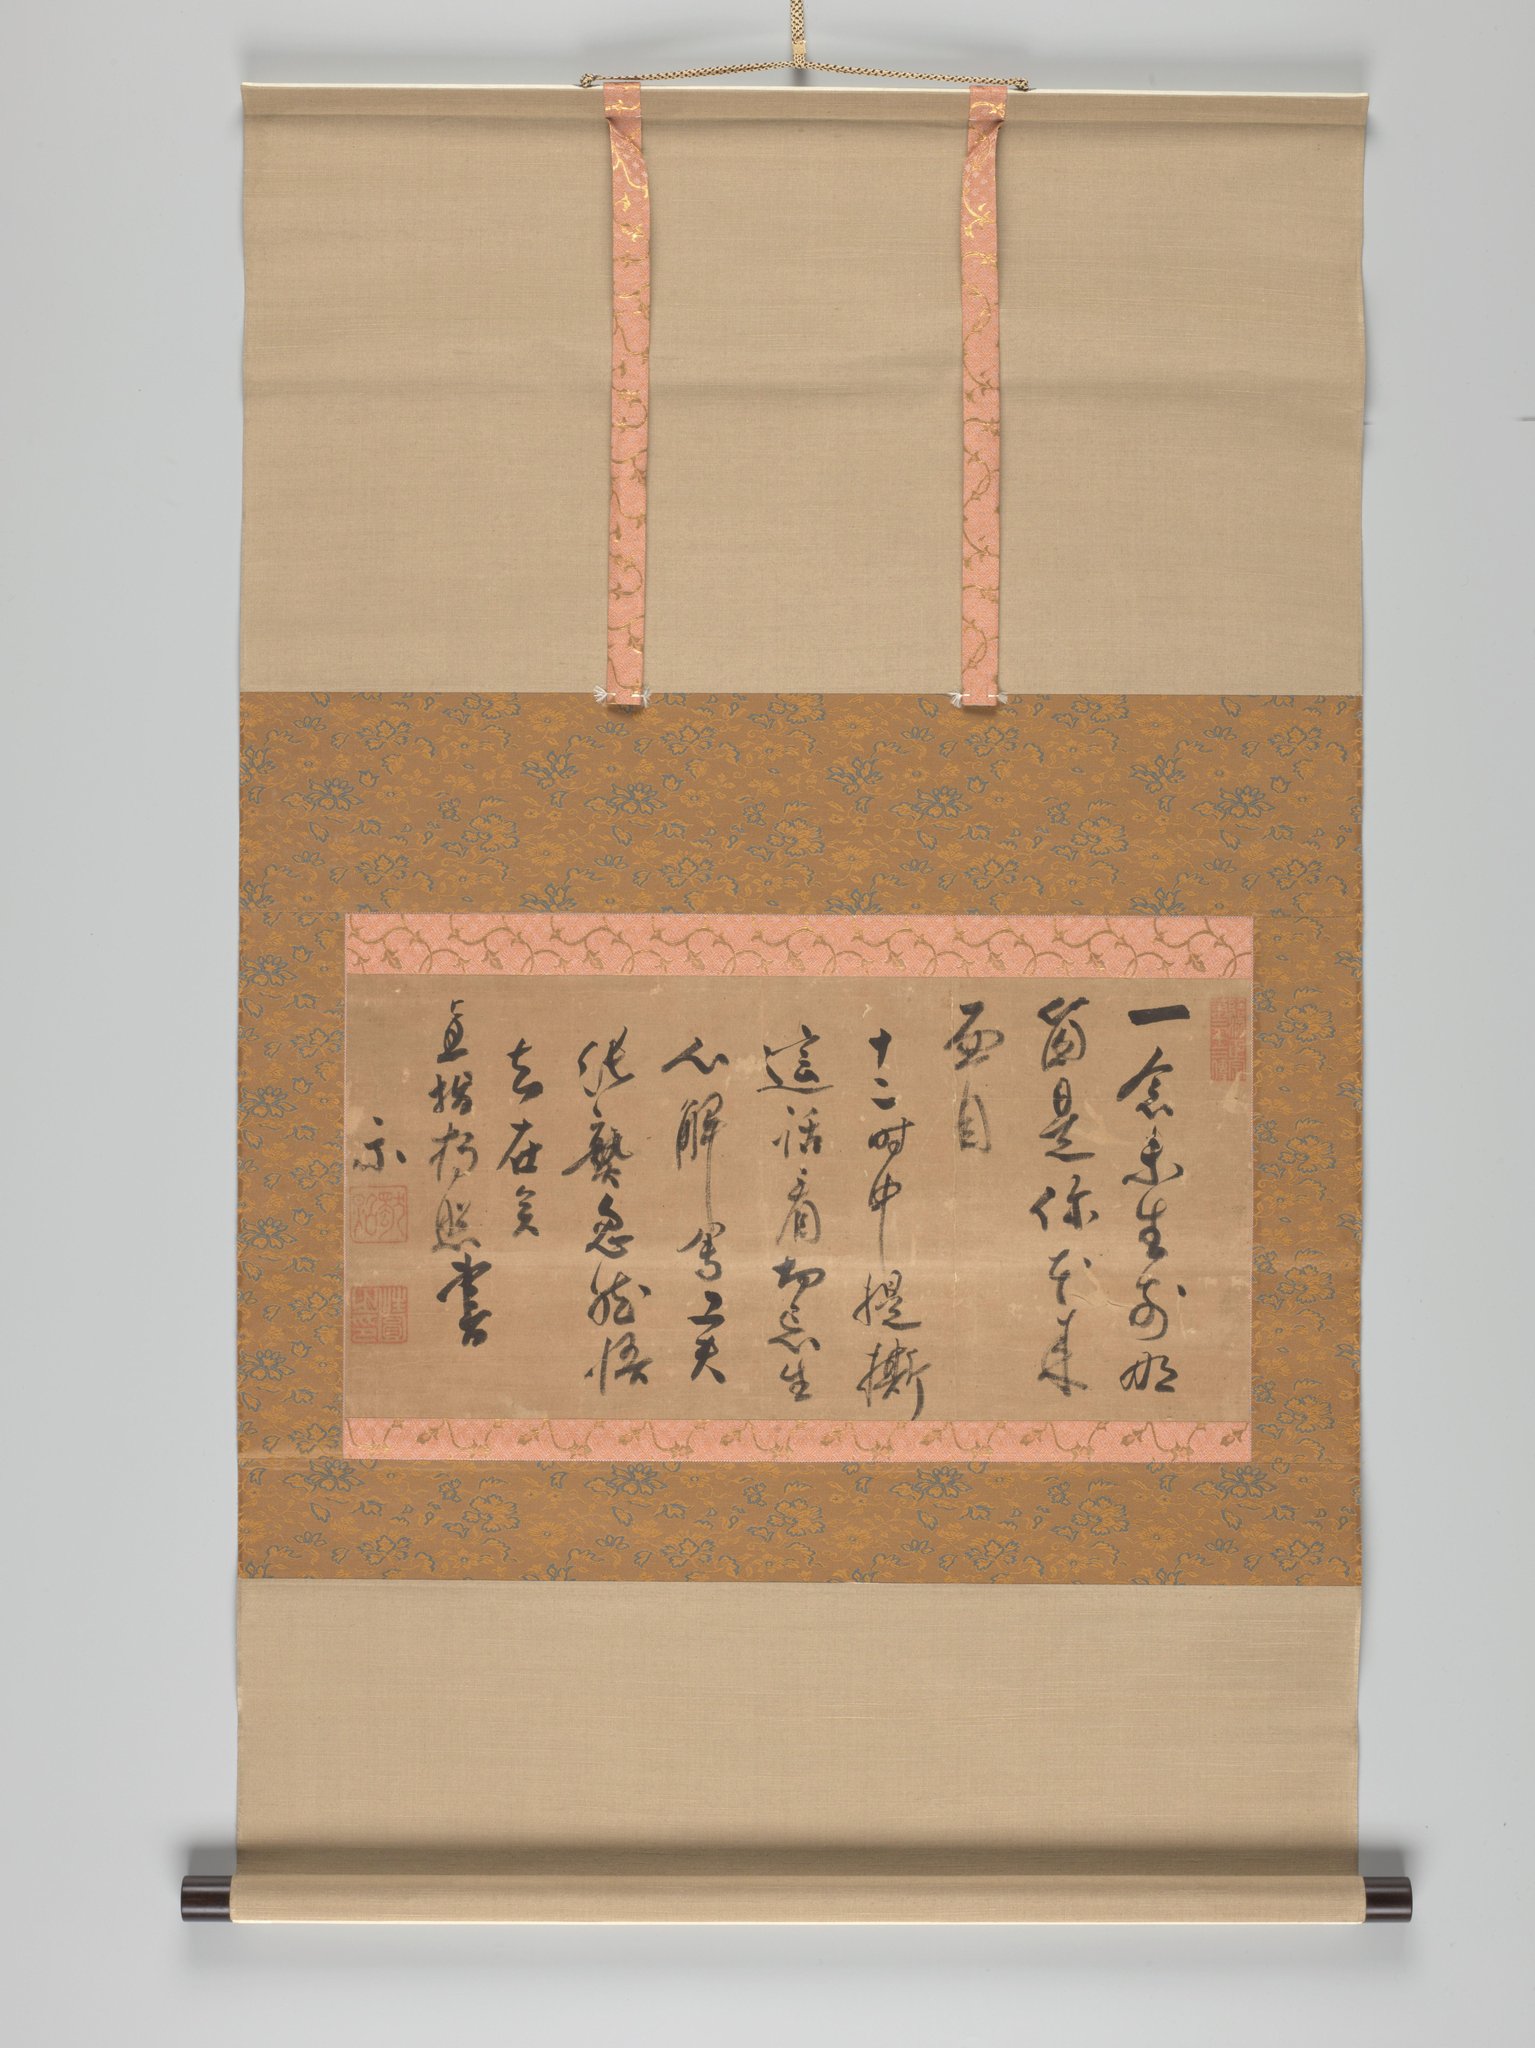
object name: hanging scroll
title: Calligraphy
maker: dokushō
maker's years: 1617-1694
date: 1617-1694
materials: ink, paper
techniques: calligraphy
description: With this calligraphic inscription, Dokusho put ‘doing’ at the centre. He contended that one cannot properly understand oneself through rational analysis, but rather by directly engaging with Zen practice.